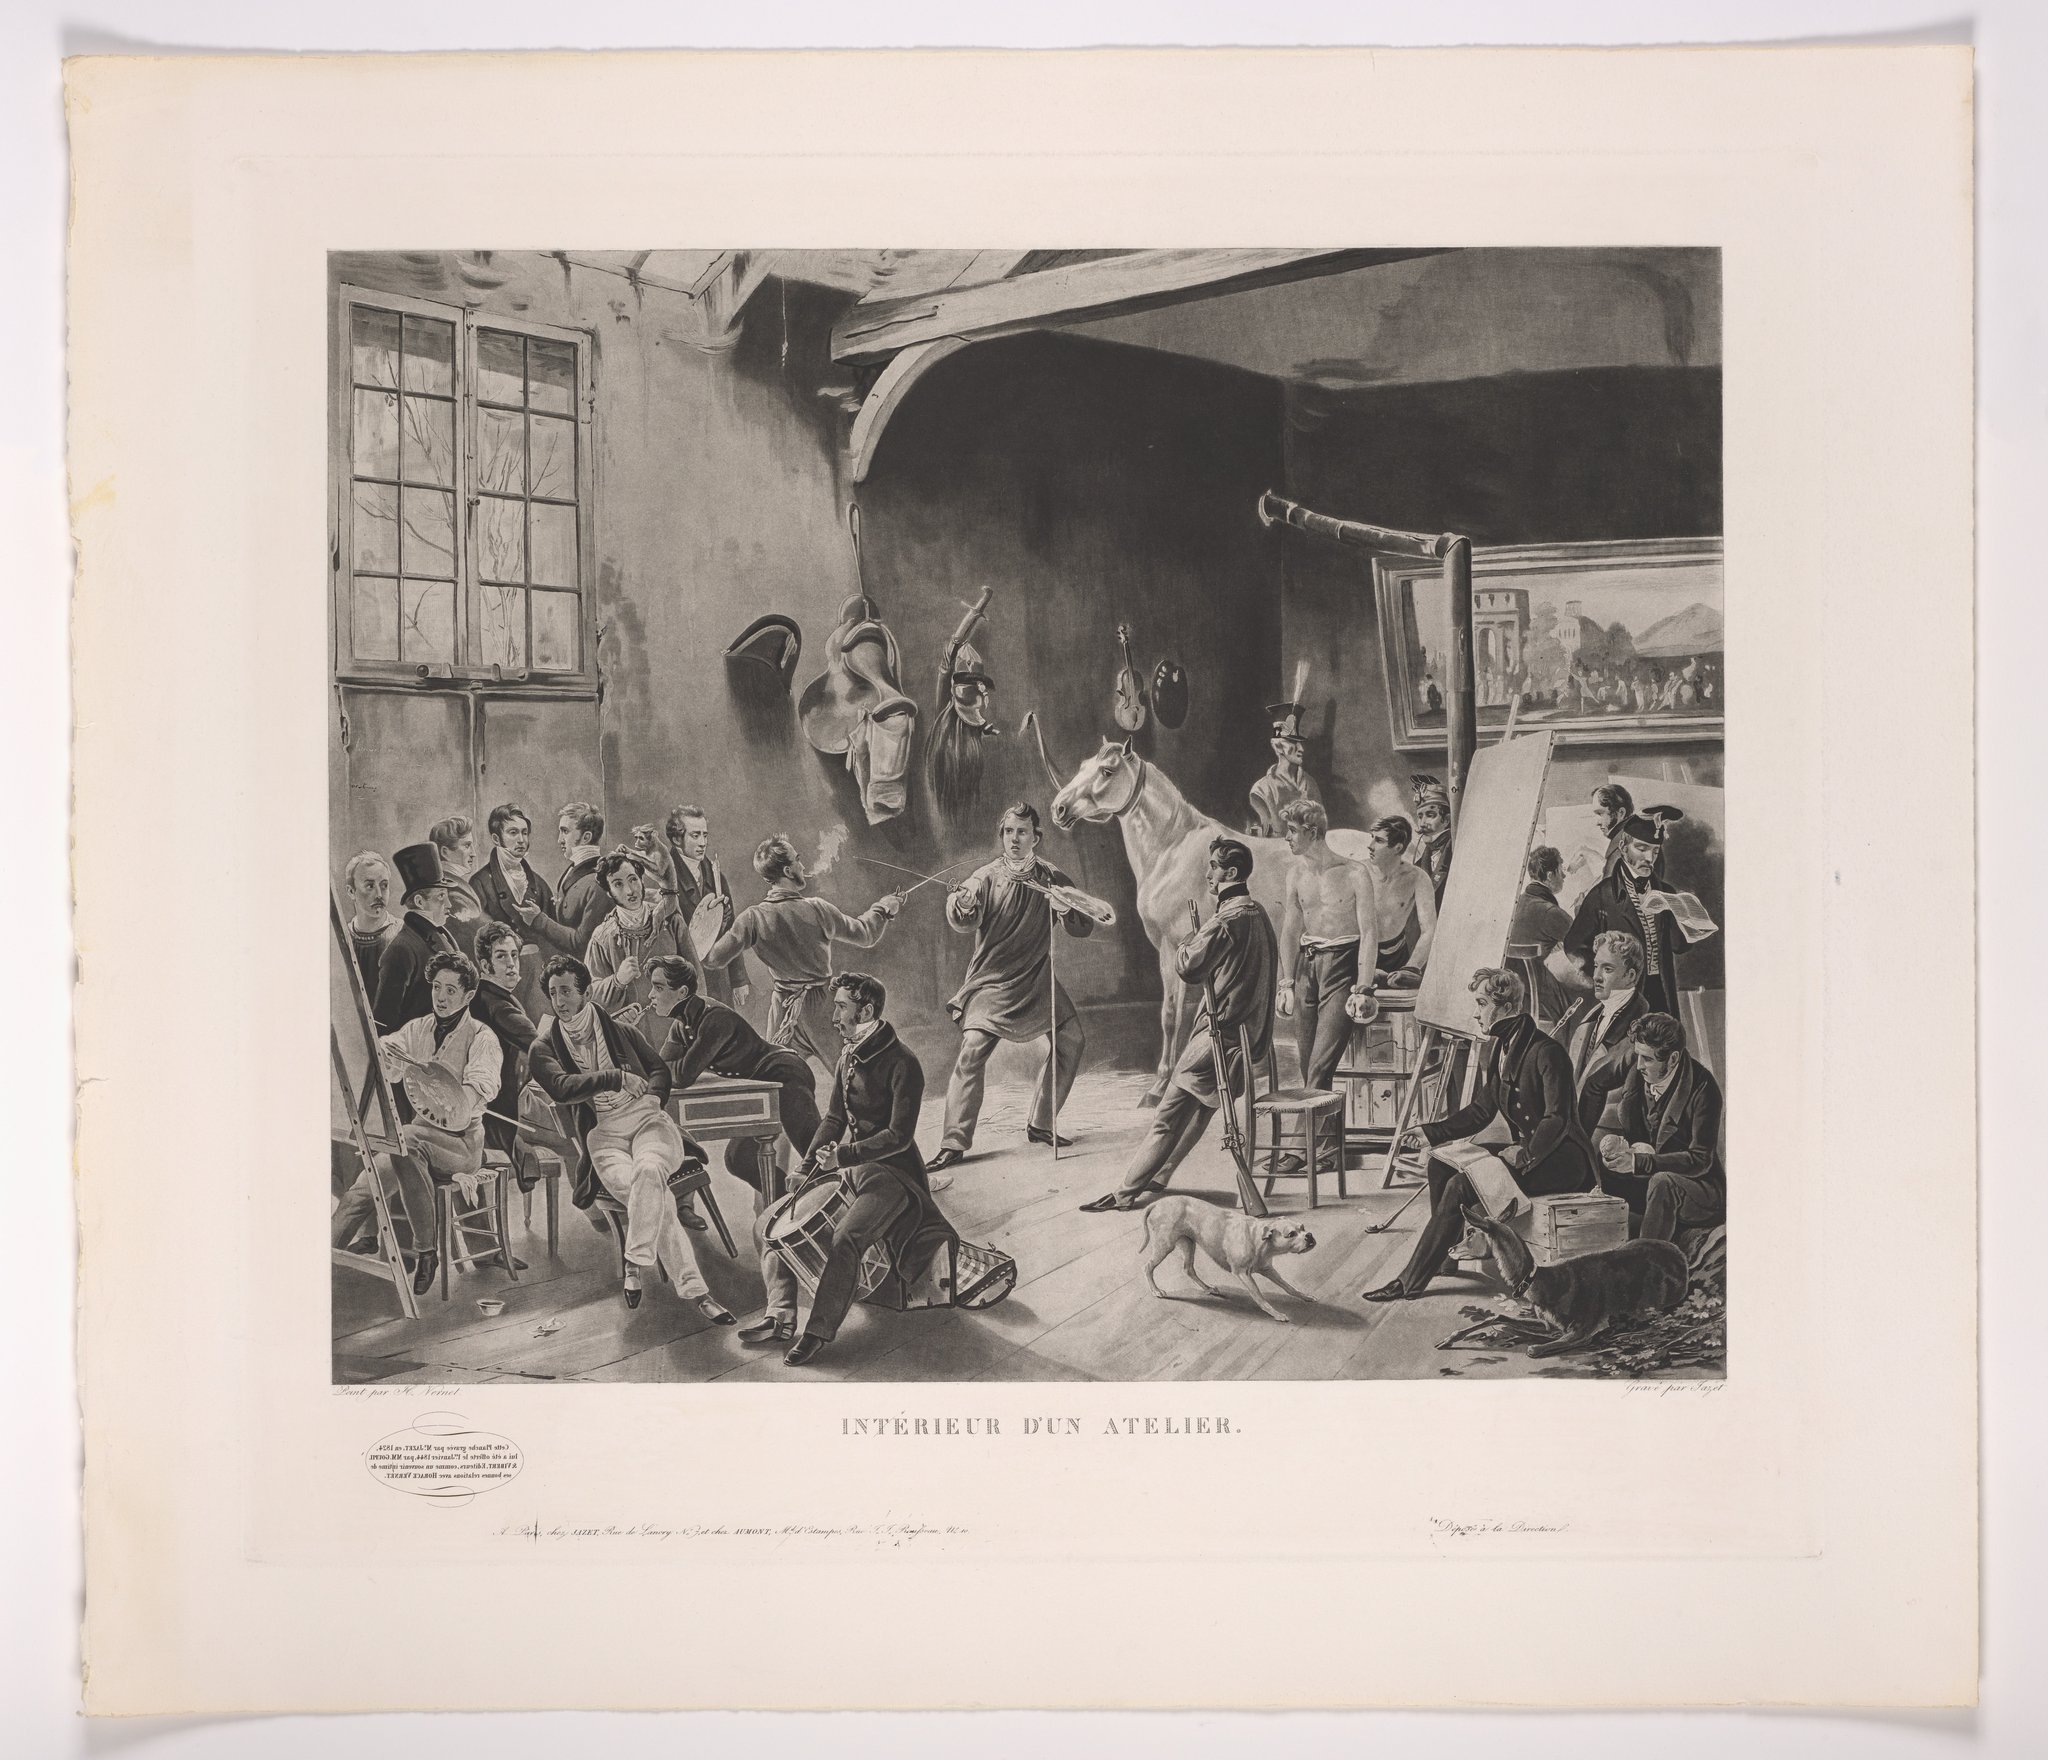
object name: print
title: The Studio of Horace Vernet (Intérieur d'un Atelier), 1824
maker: horace vernet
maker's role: artist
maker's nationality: french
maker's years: 1789-1863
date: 1824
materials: paper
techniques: aquatint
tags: painting,men,dogs,horses,artists